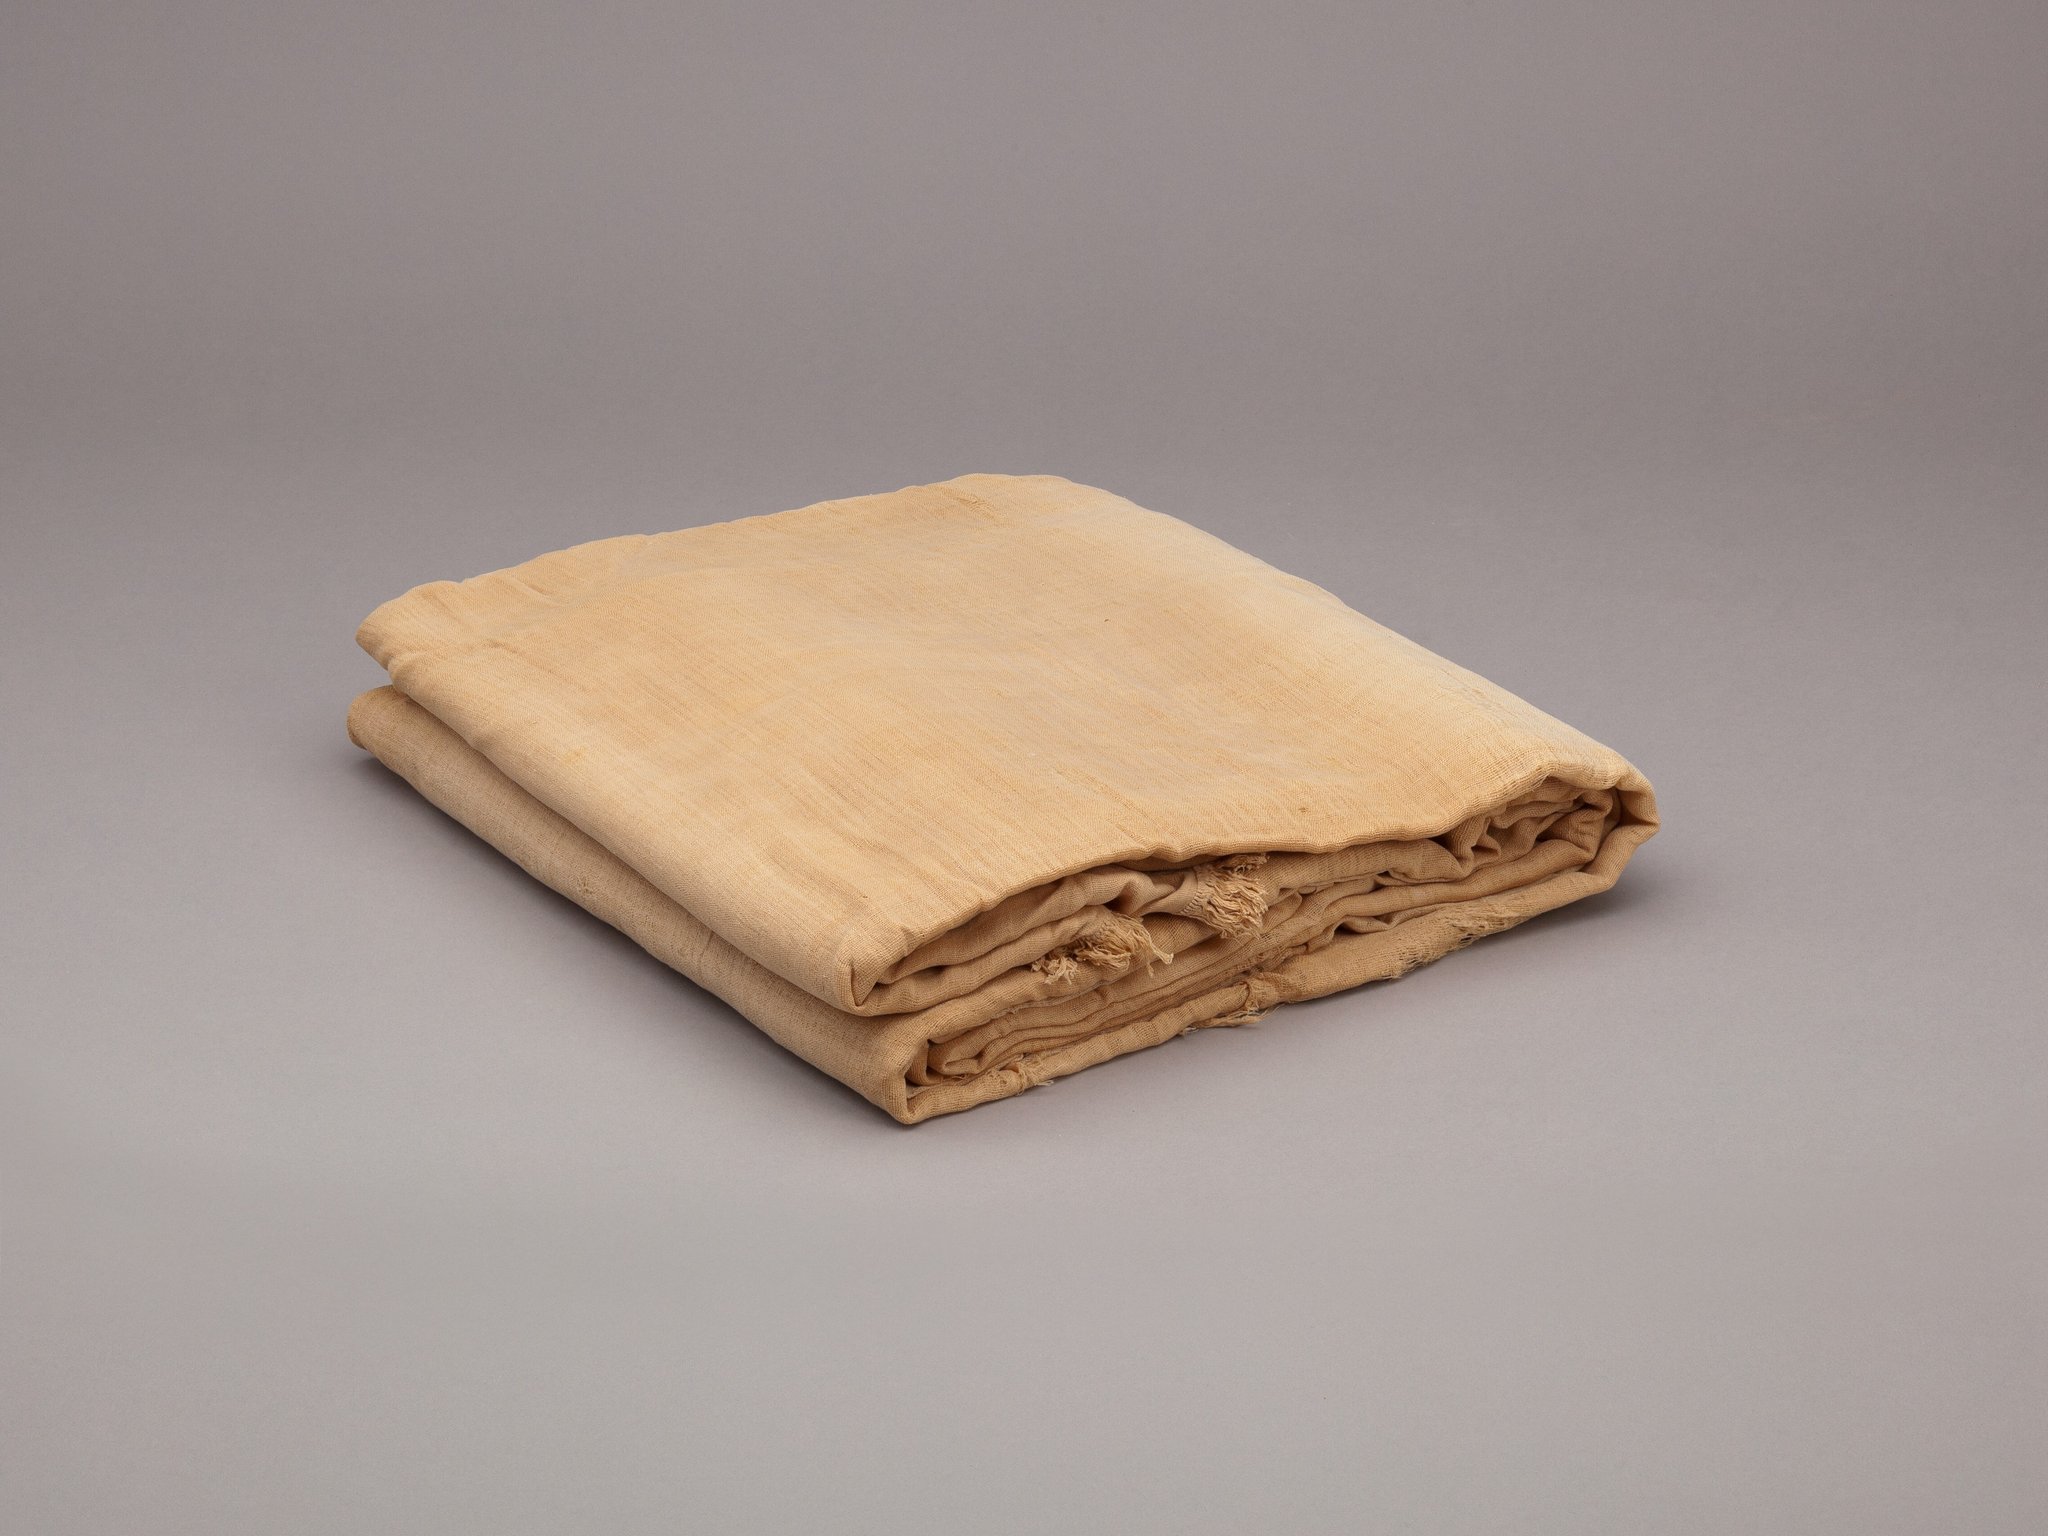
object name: linen mark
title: Sheet, linen mark, medium spin, close weave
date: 1492-1473 BCE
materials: linen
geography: egypt